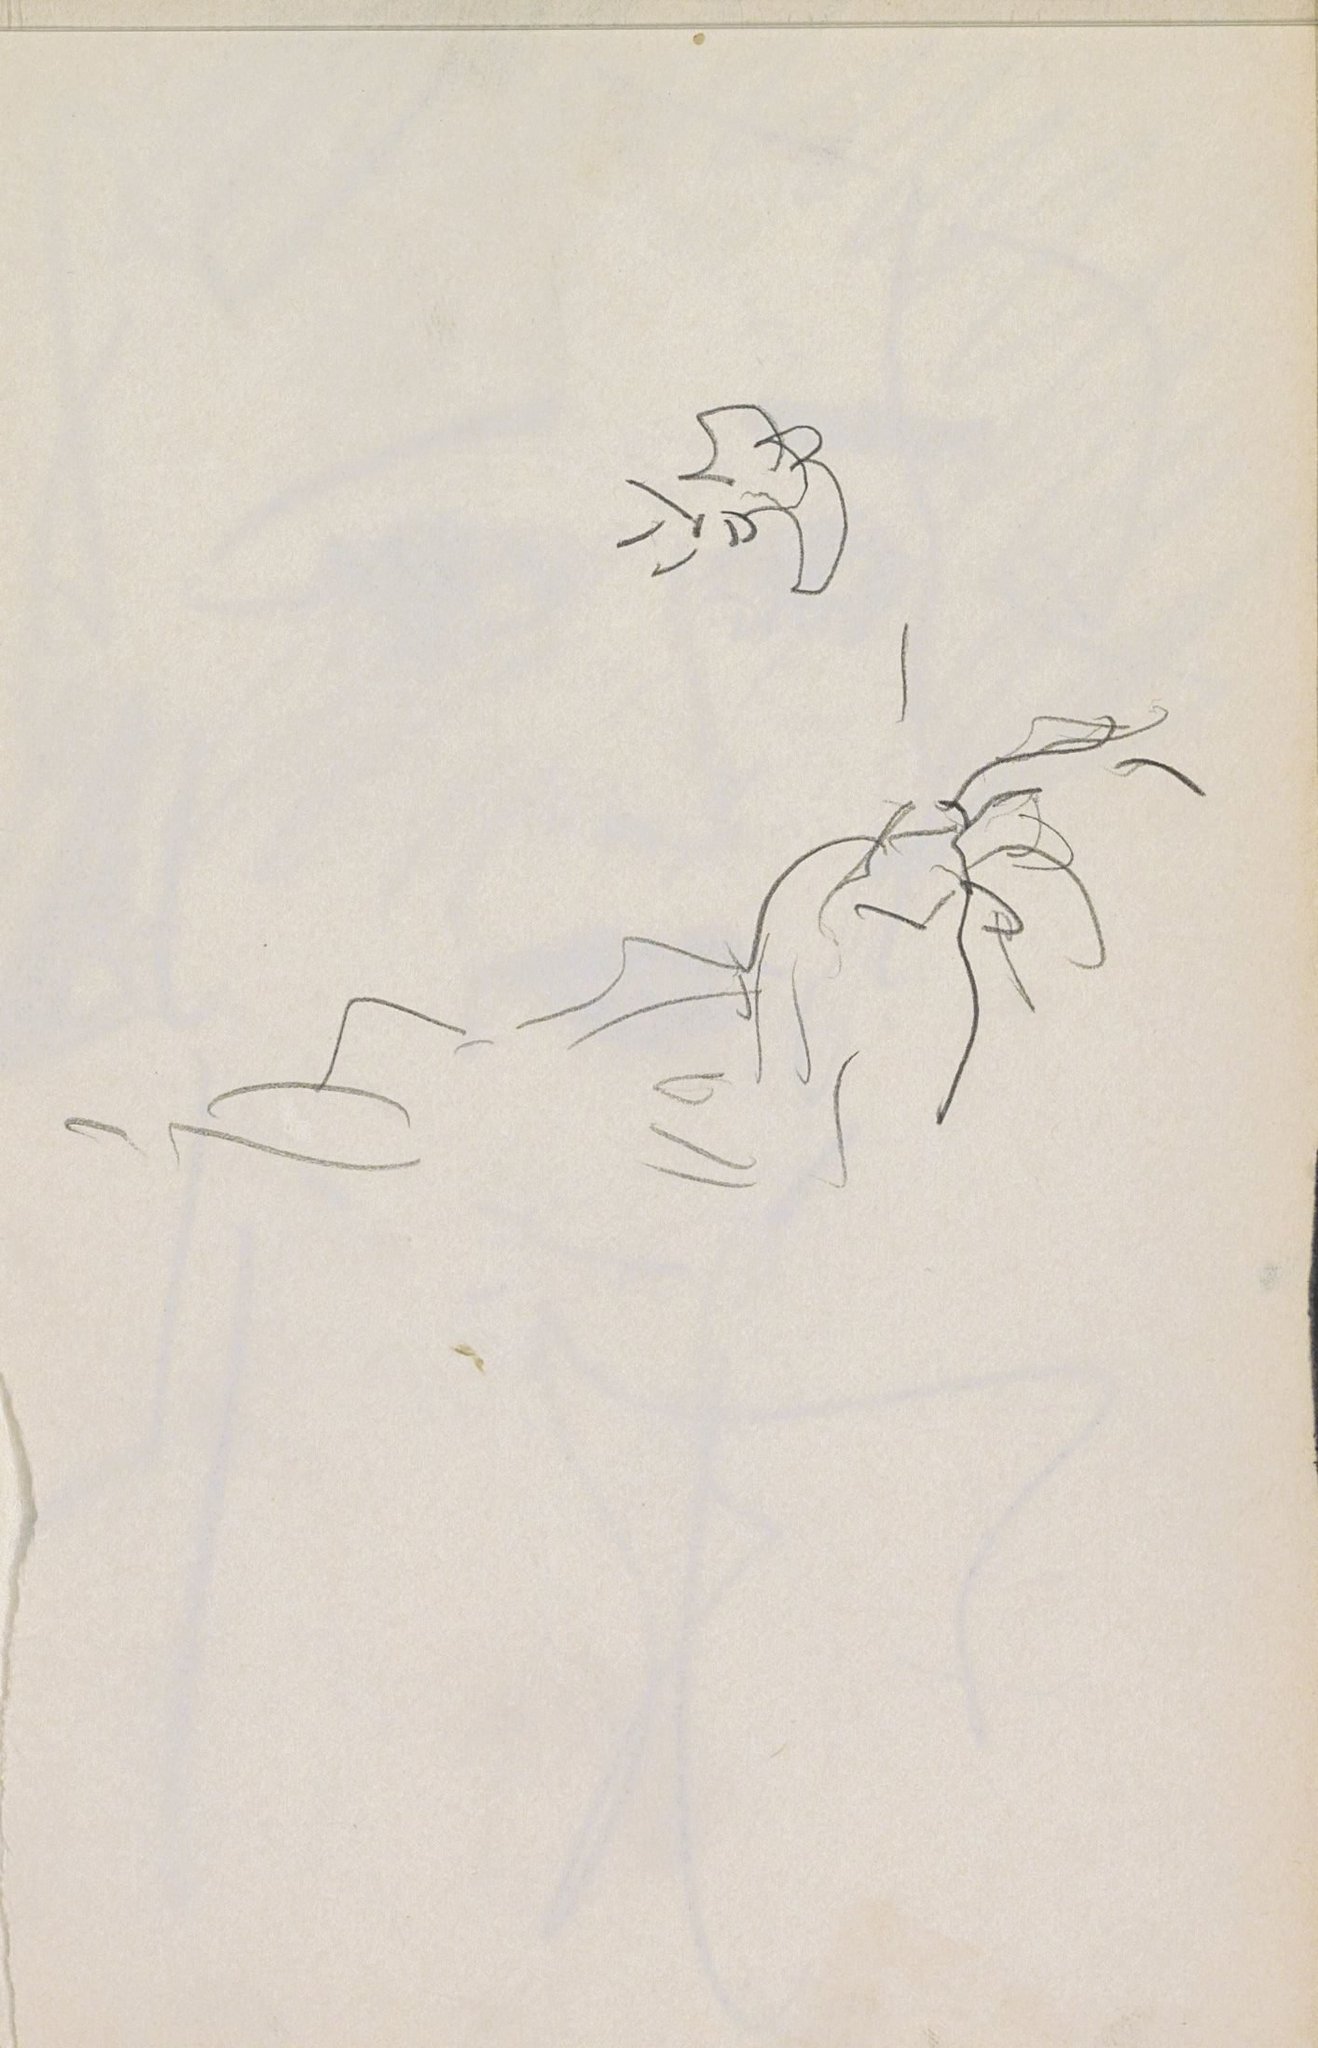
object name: sketchbook leaf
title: Figuurstudies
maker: isaac israels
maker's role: draughtsman, painter, print maker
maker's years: 1865-1934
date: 1875-1934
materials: paper, pencil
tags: the (nude) human figure; 'corpo humano' (ripa)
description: Blad 2 recto uit schetsboek LII met 43 bladen.